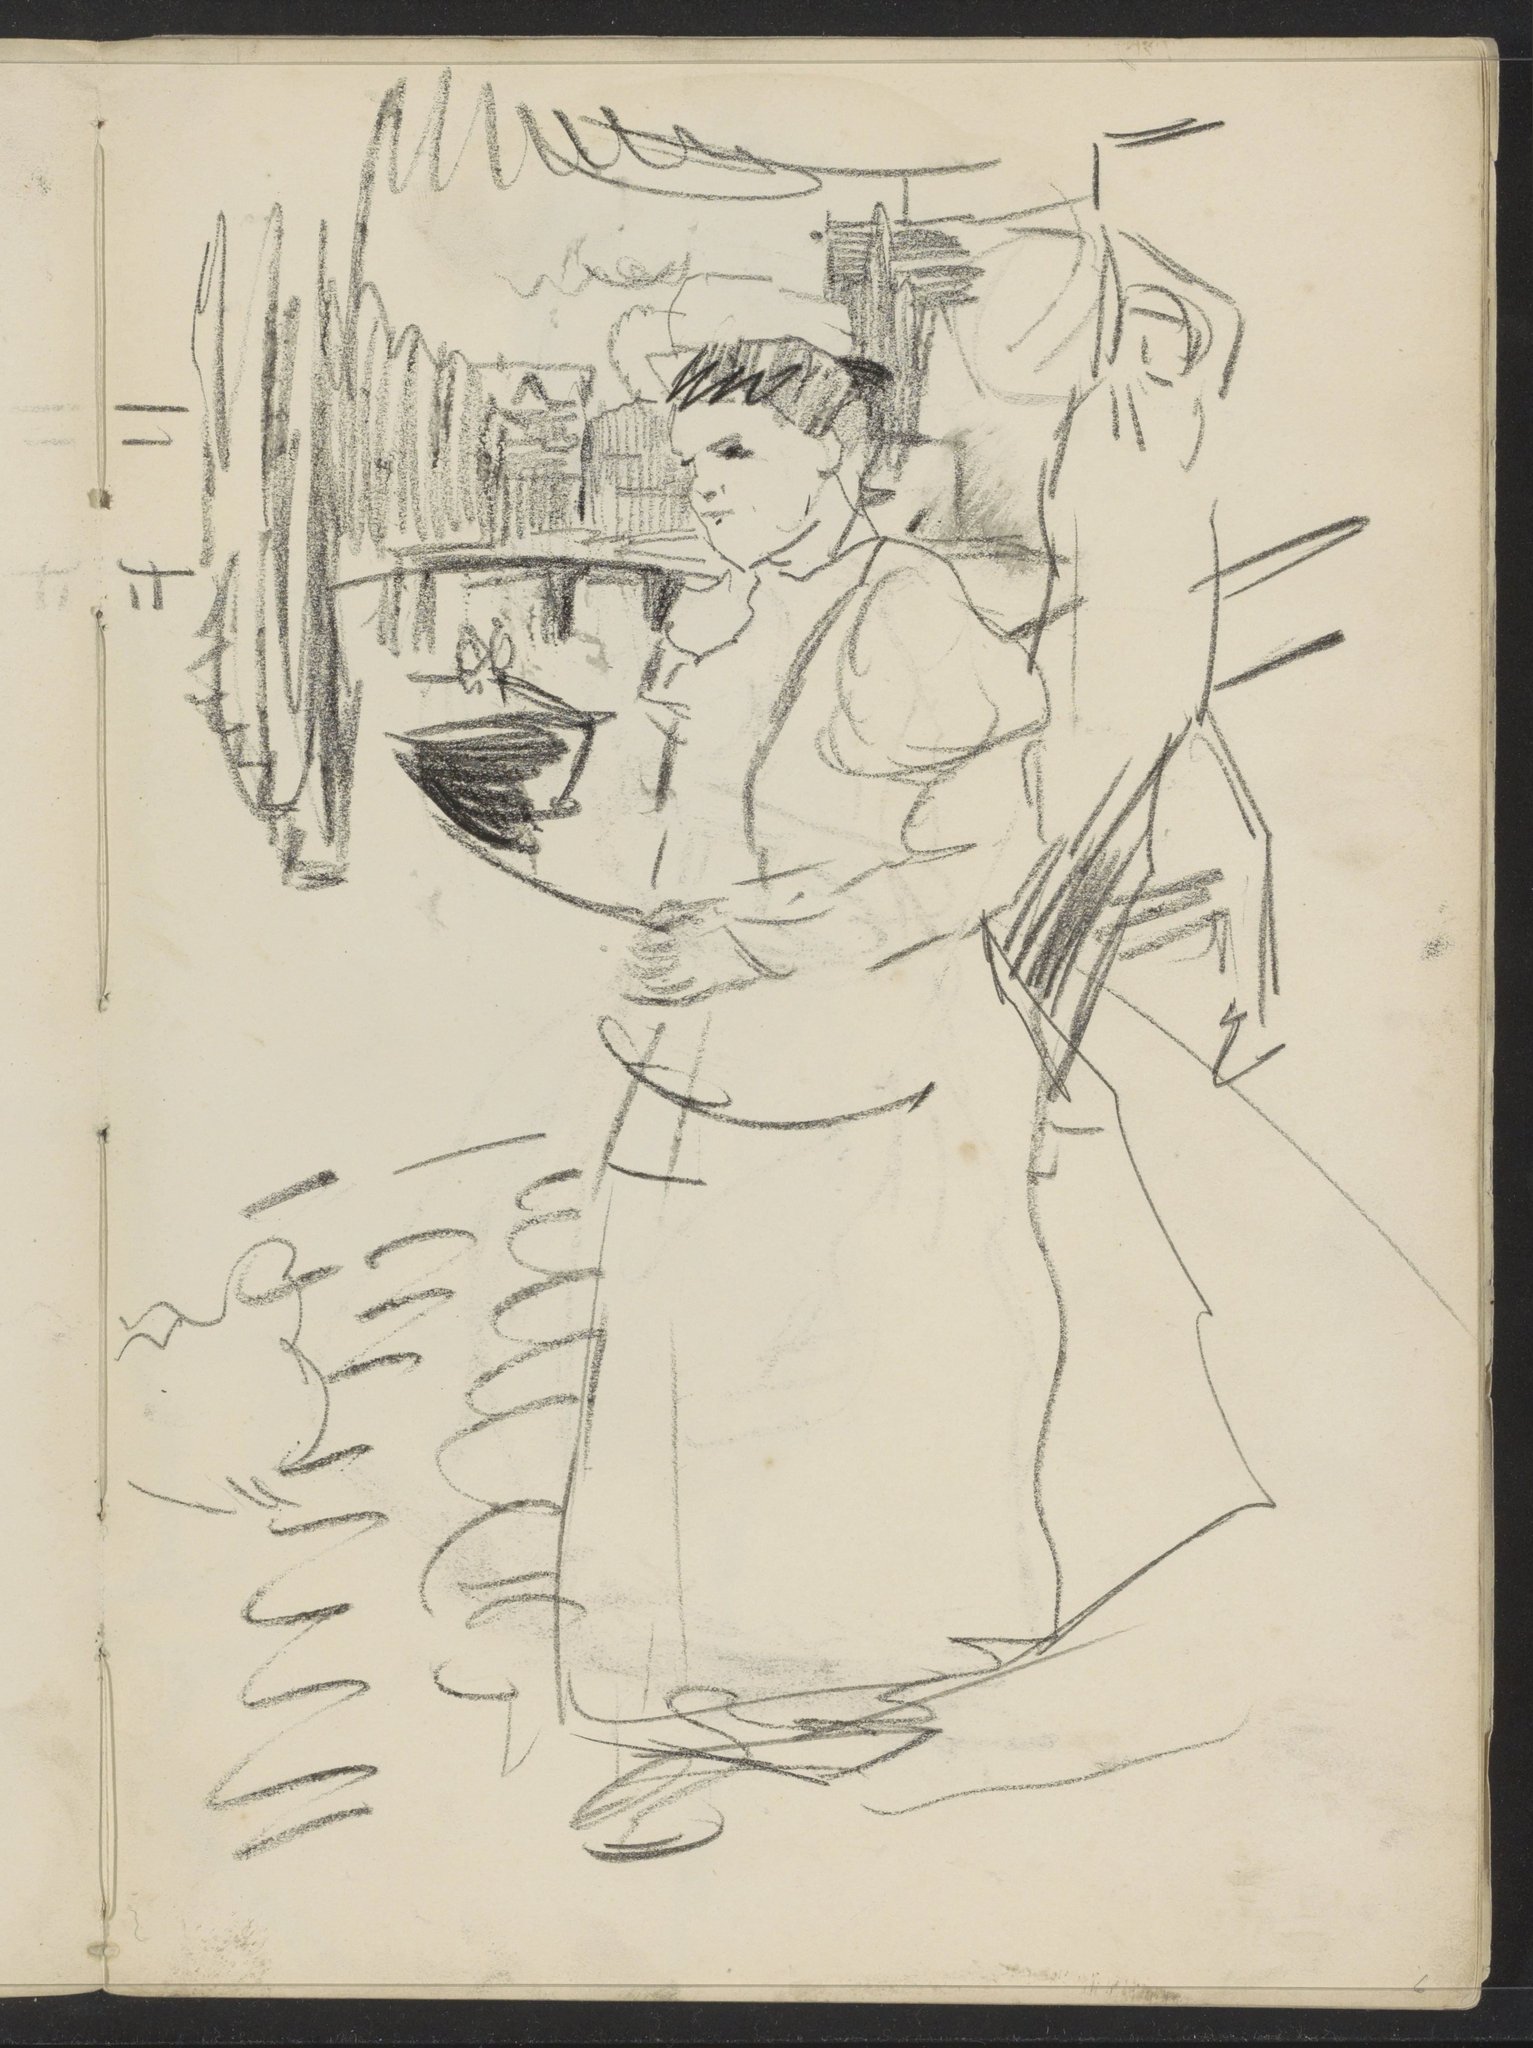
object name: sketchbook leaf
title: Dienstmeid op de Herengracht te Amsterdam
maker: isaac israels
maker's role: draughtsman, painter, print maker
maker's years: 1865-1934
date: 1886-1934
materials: chalk, paper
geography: amsterdam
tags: bowl, maid ~ house personnel, walking - aa - female human figure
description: Bij de brug over de Brouwersgracht. In haar hand een mand of kom. Achter haar een sjouwer. Blad 6 recto uit schetsboek LXVI-B met 25 bladen.